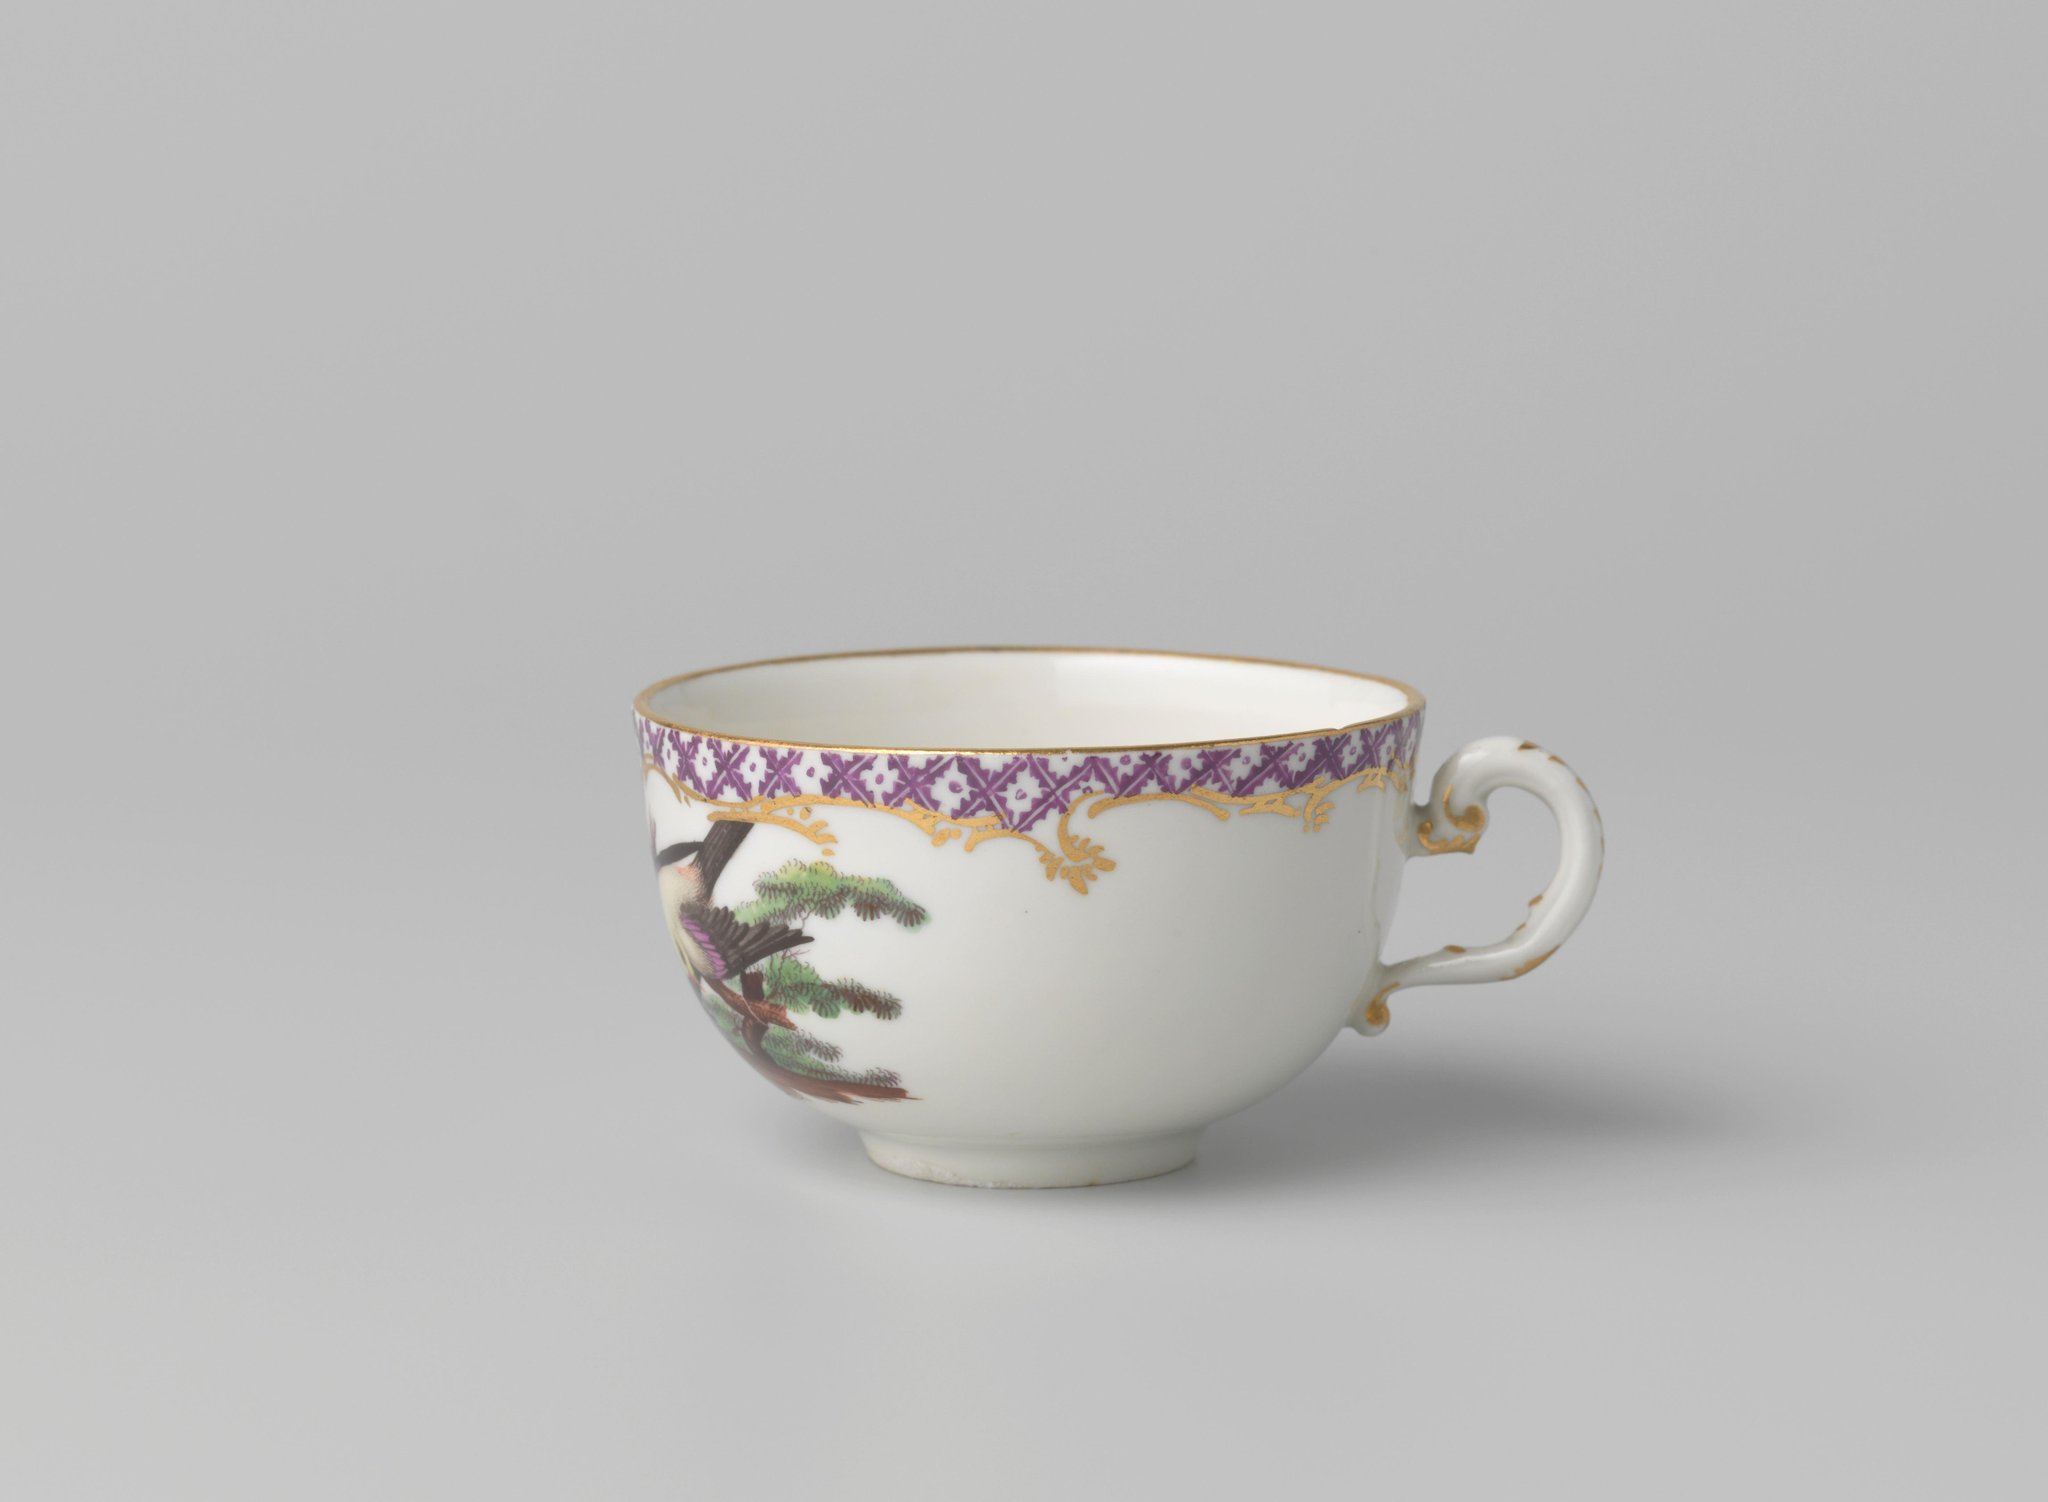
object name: cup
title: Cup with birds in a landscape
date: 1765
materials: glaze, gold, paint, porcelain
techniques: firing, forming, gilding, turning, vitrification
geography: ansbach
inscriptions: mark: ‘A/ I’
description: Kop van porselein en een gekruld oor in de vorm van een bladrank, beschilderd op het glazuur in emailkleuren en goud. Op de buitenwand vogels in een landschap. De buitenrand met een band met servetwerk, waaronder gouden ranken. Strooibloemen op de bodem. Gouden rand. Gemerkt op de onderzijde met de A en I.